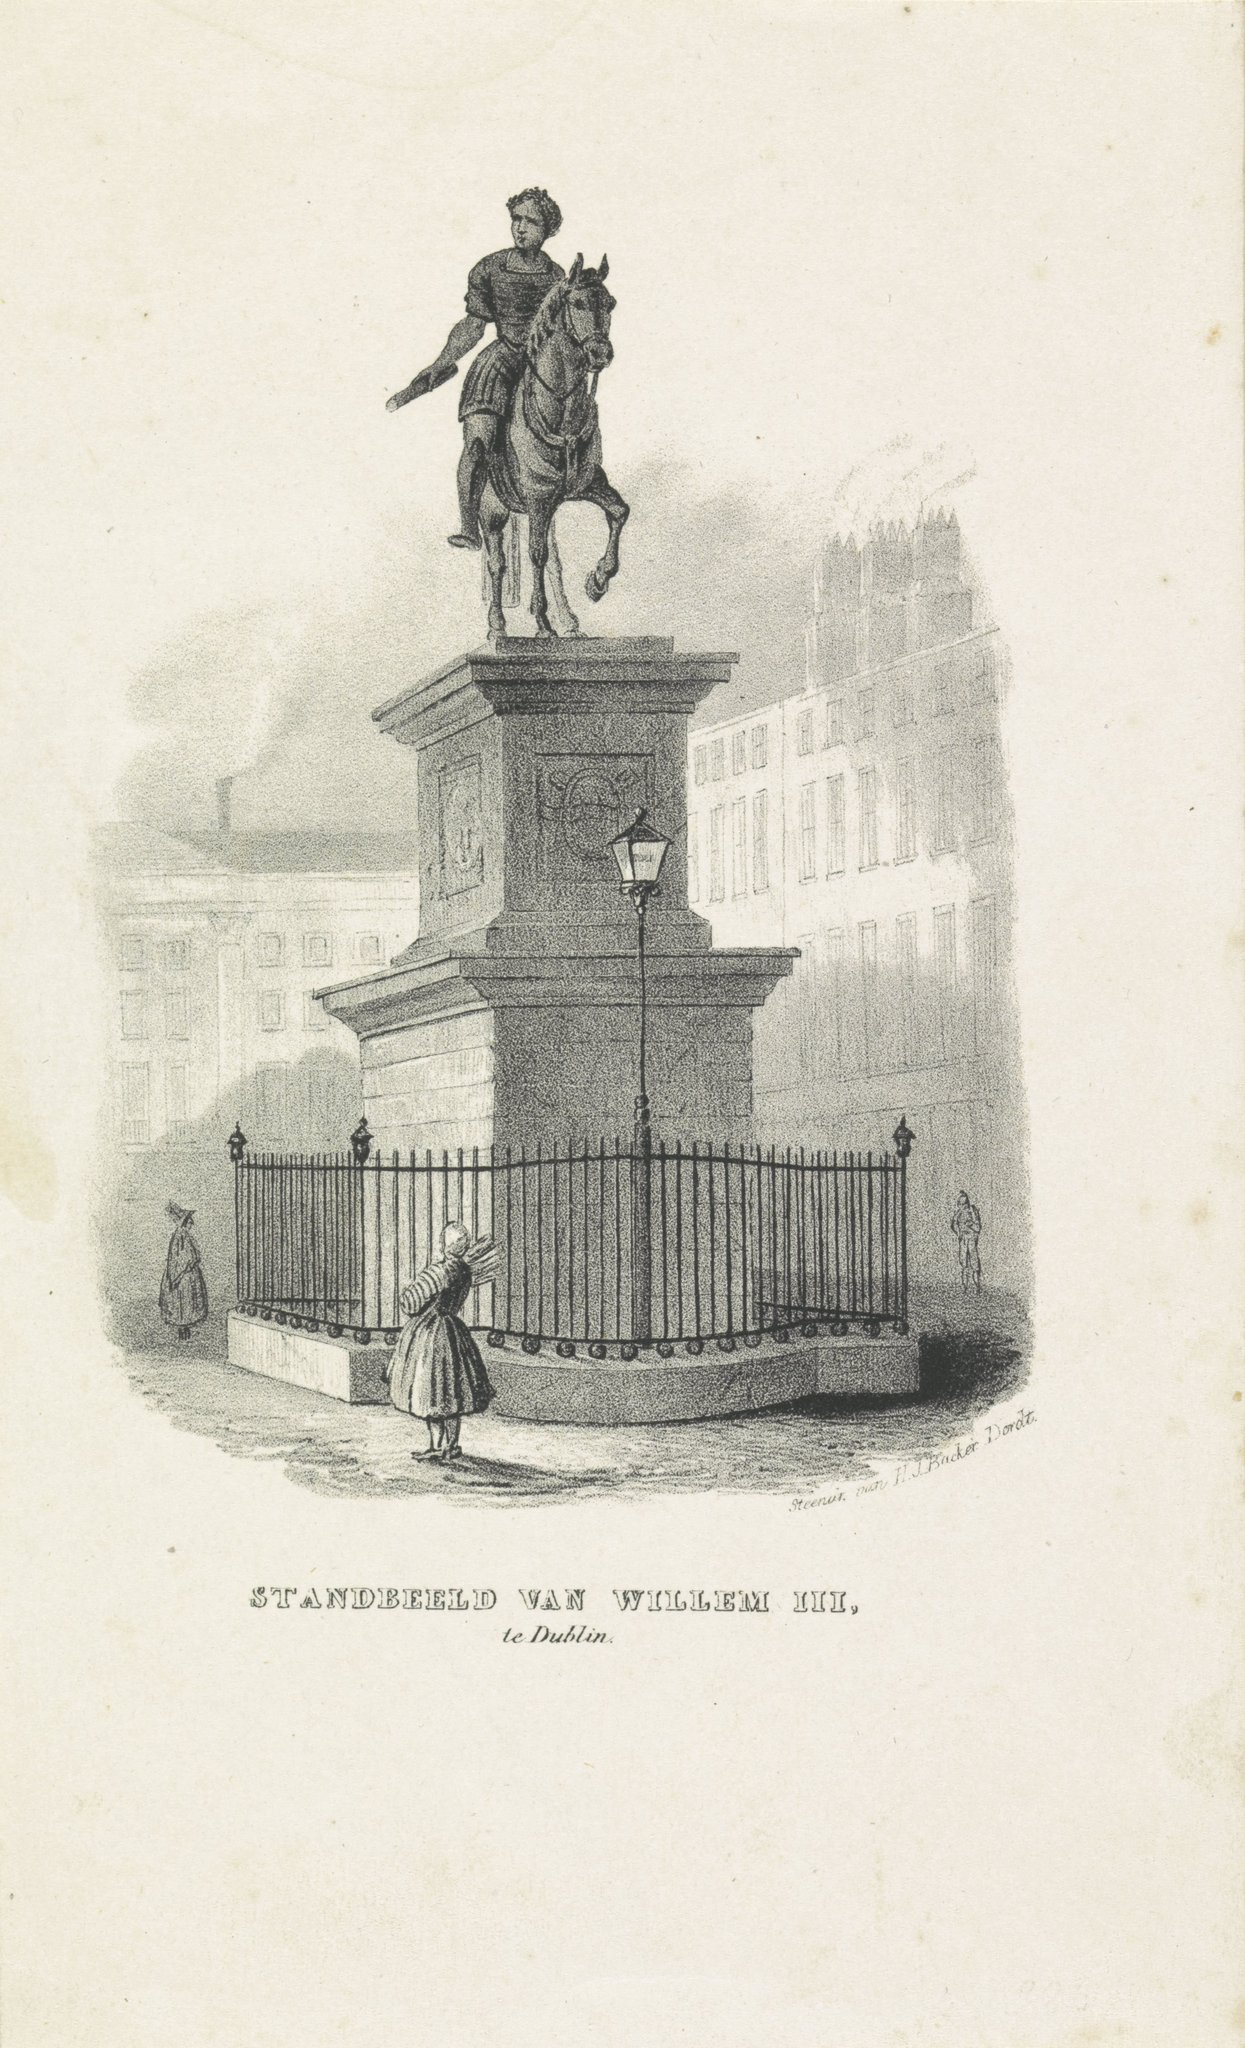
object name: print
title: Ruiterstandbeeld van Willem III, prins van Oranje, te Dublin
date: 1822-1845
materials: paper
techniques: lithograph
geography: netherlands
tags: william iii (prince of orange and king of england, scotland, and ireland), equestrian statue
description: De hier vermelde titel verwijst naar de hoogst verkregen titel van de geportretteerde, niet per se naar de titel die de geportretteerde op deze voorstelling draagt.